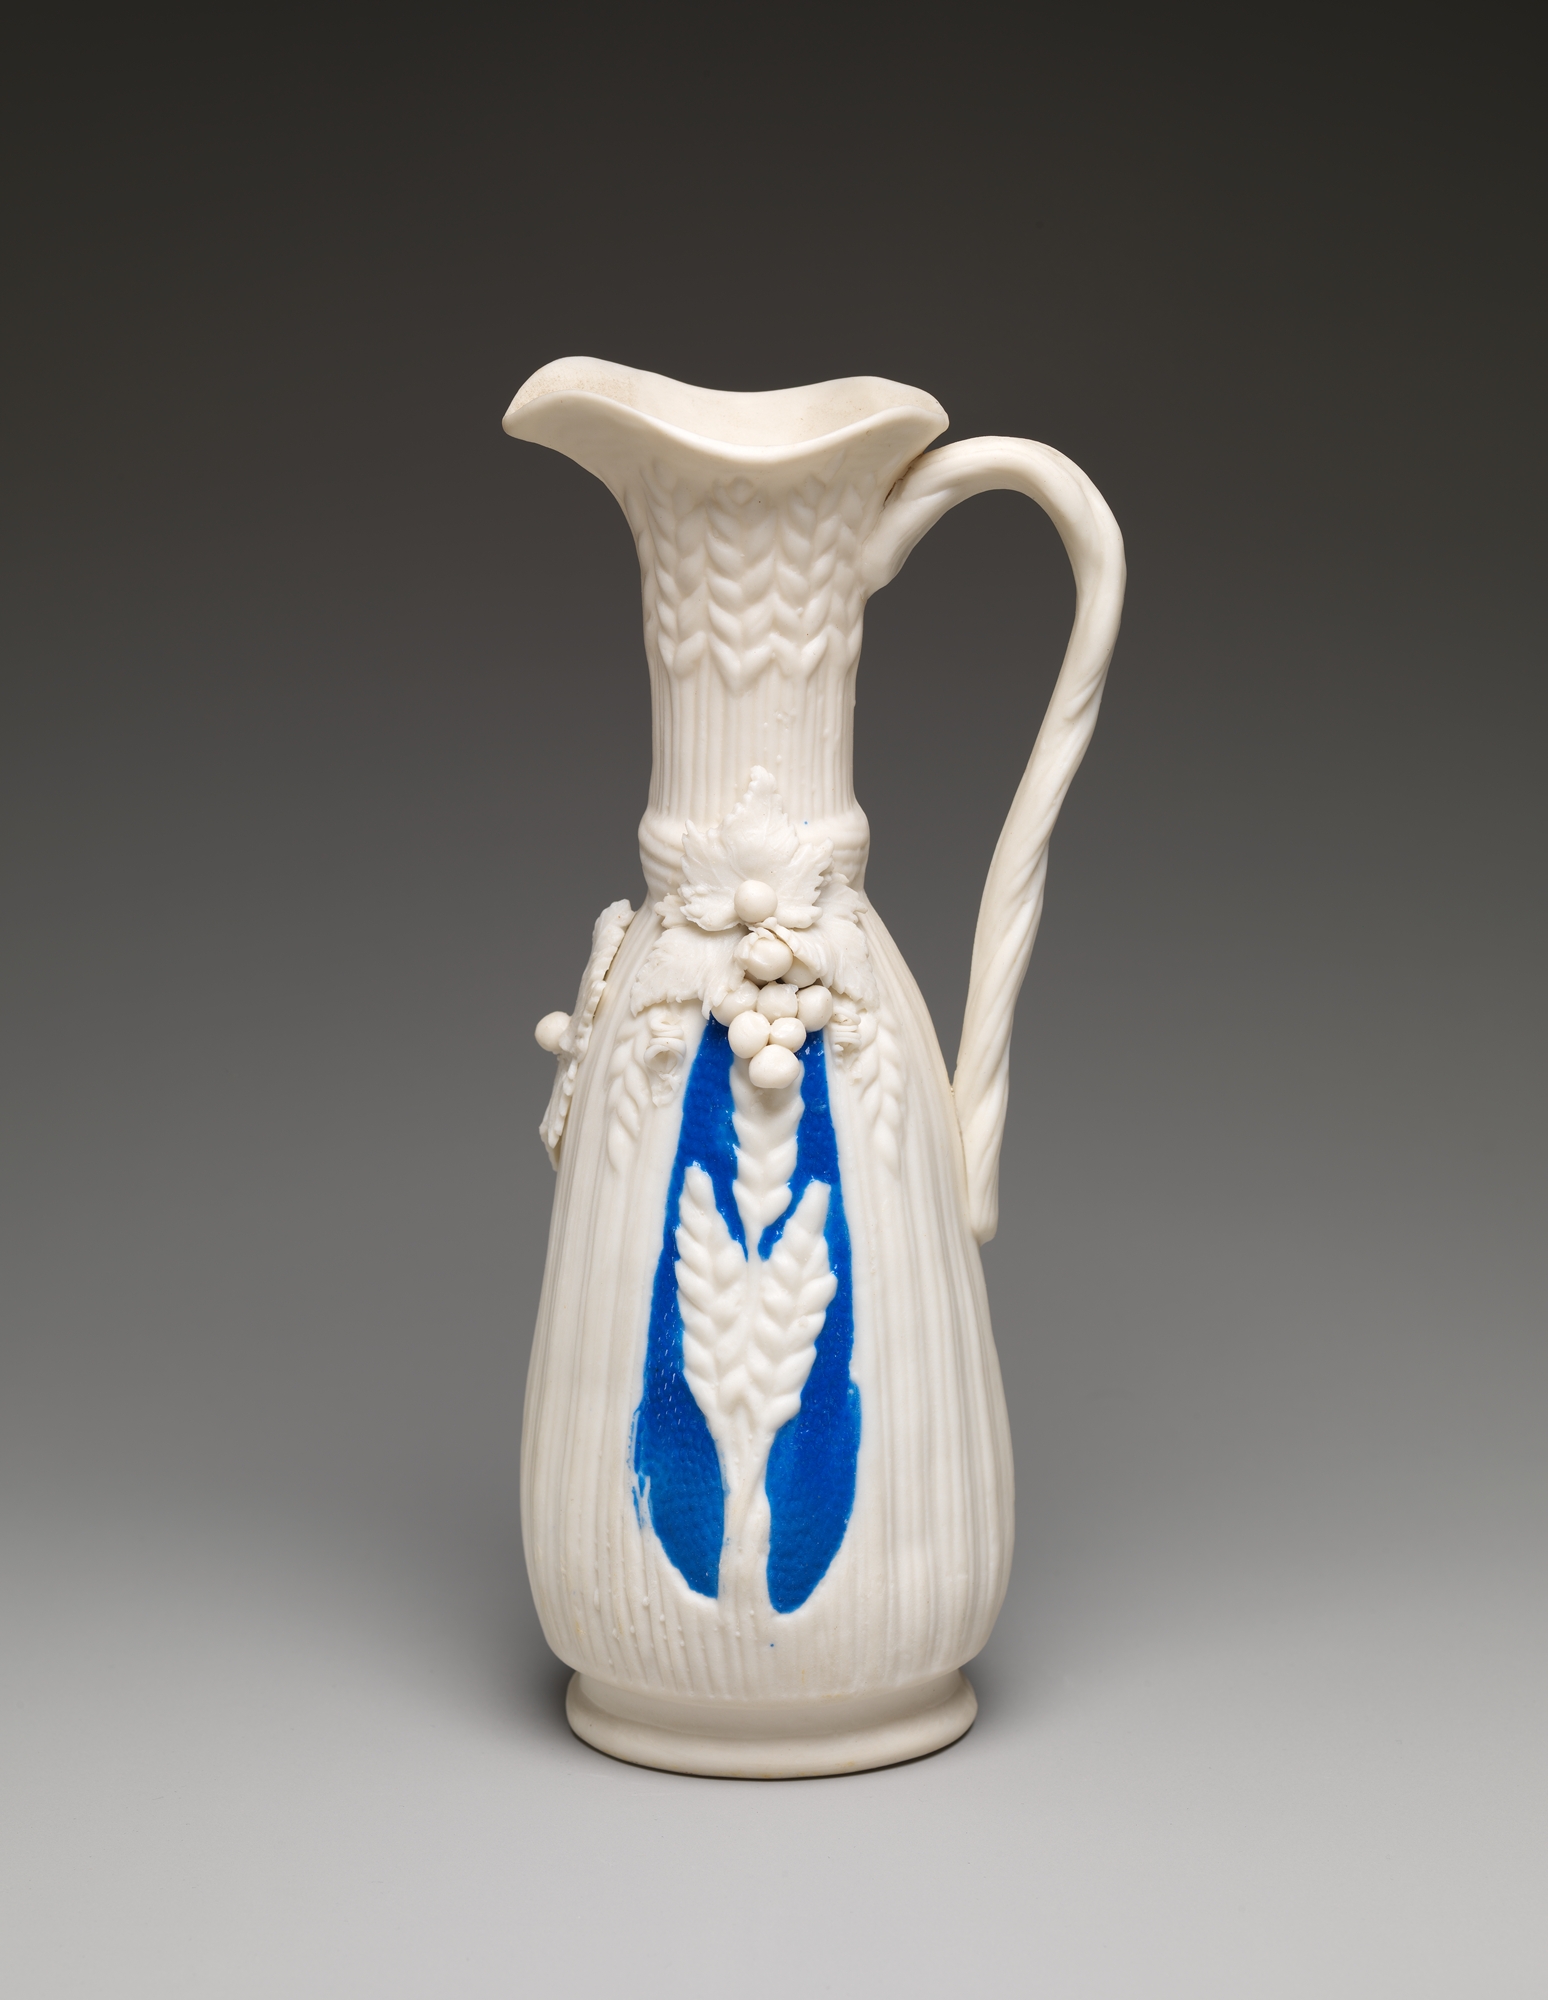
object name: pitcher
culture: american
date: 1830-1870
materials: porcelain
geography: united states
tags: grapes